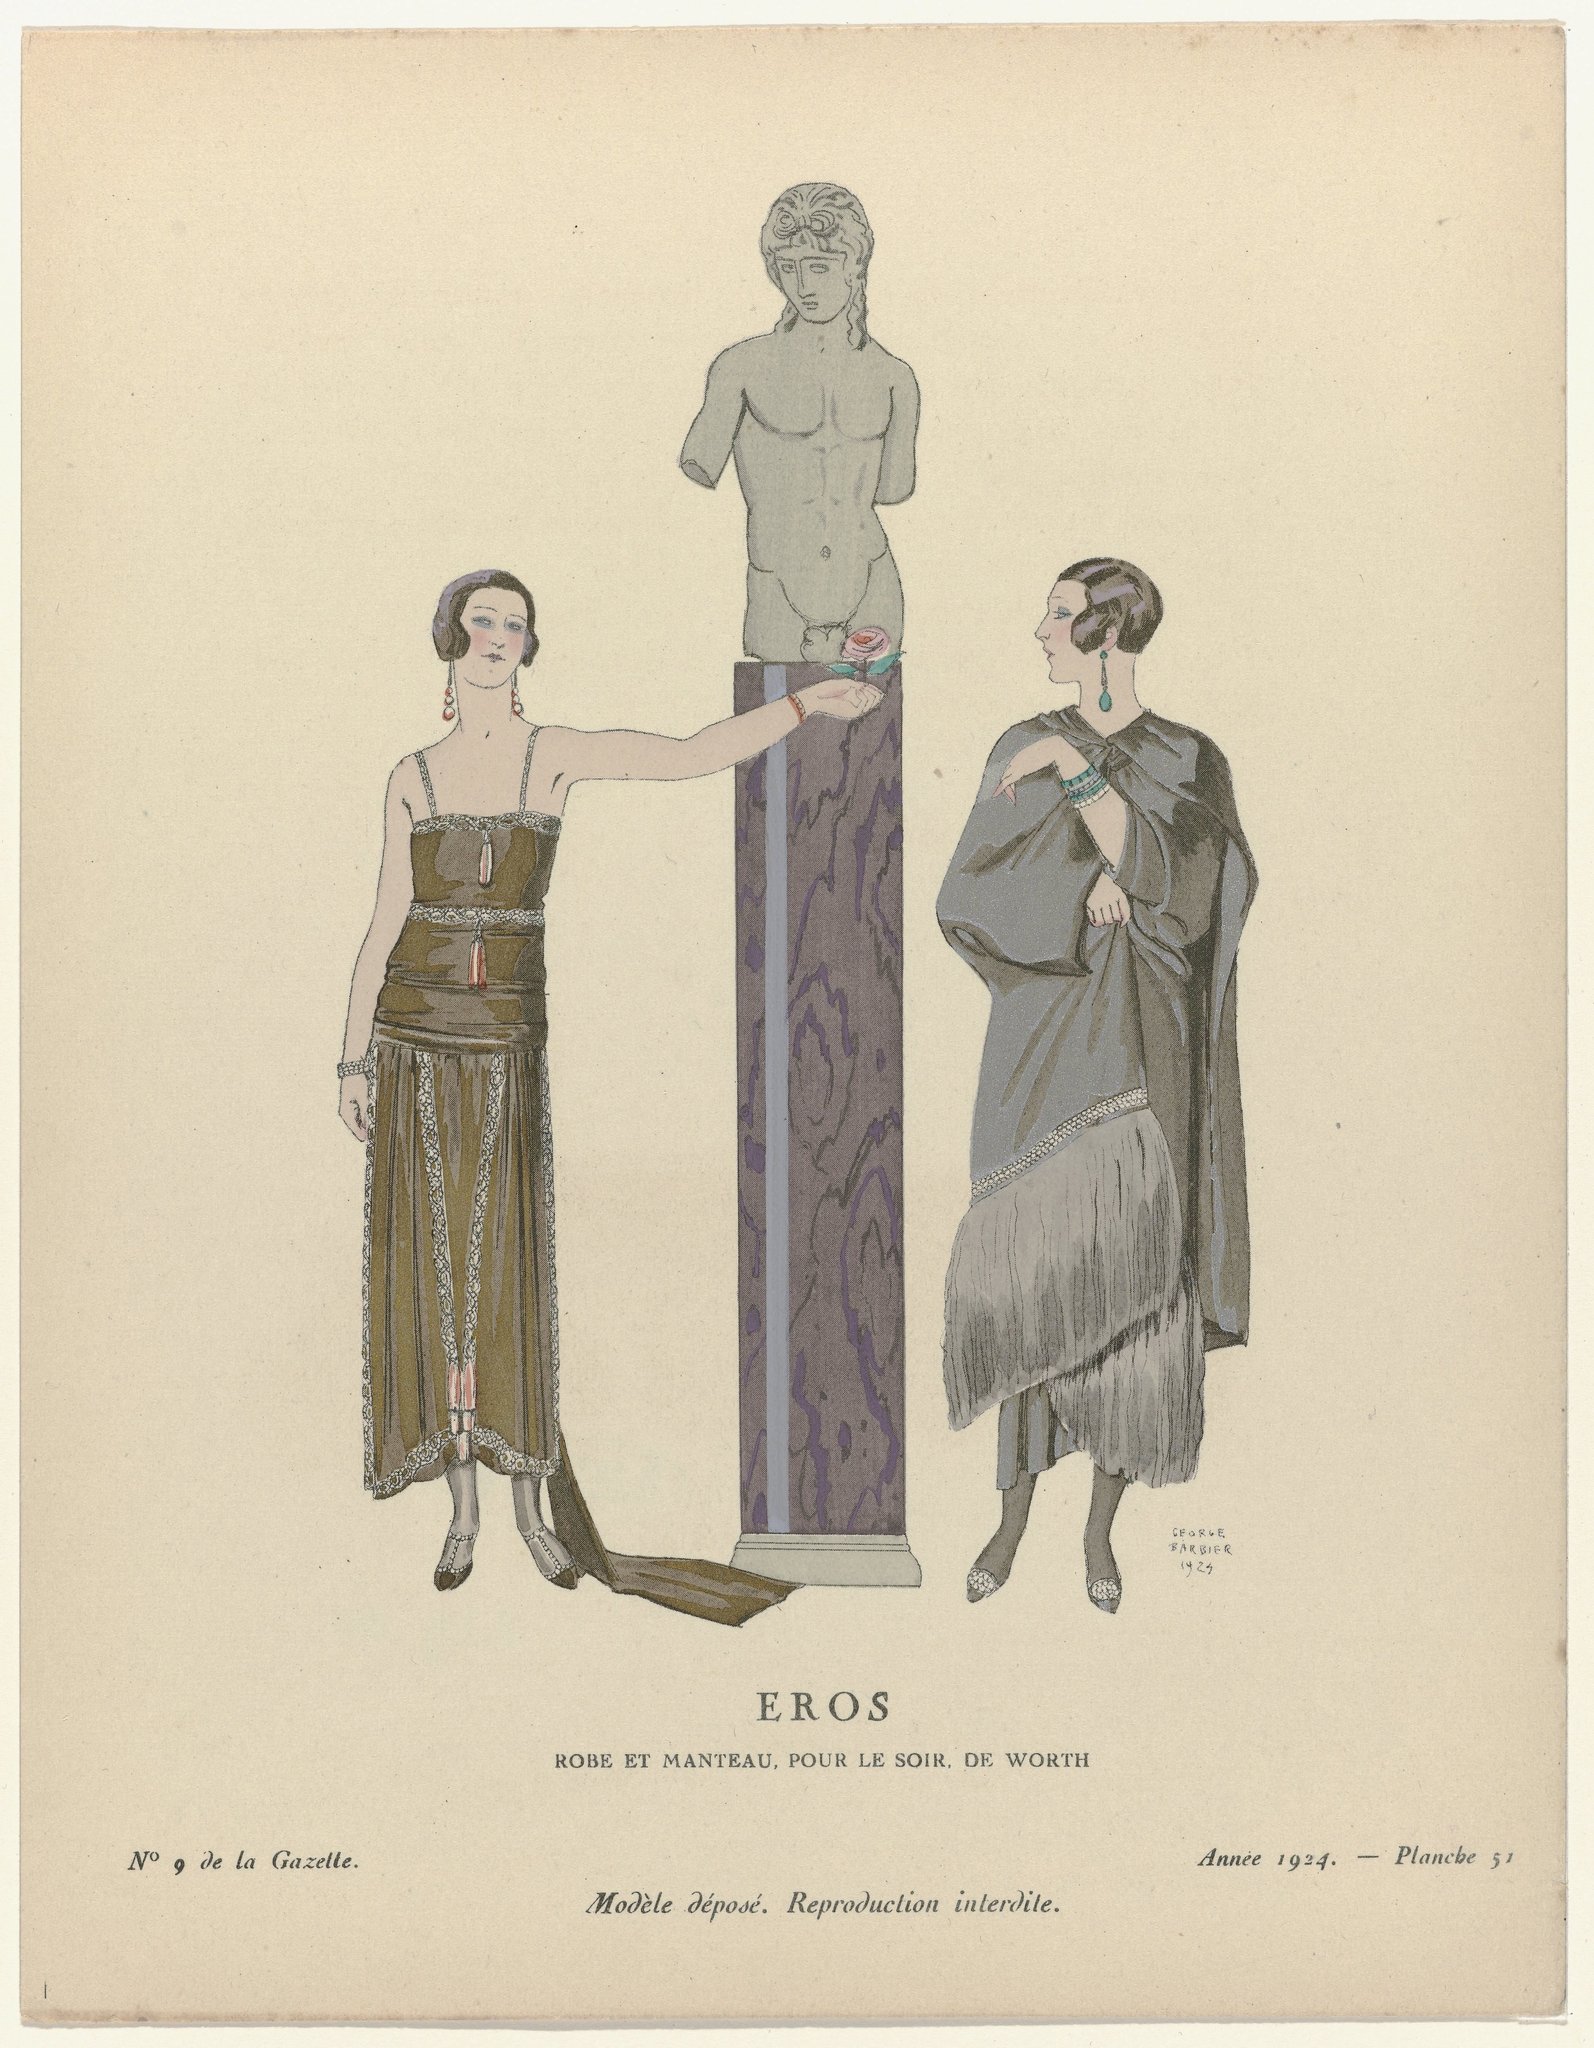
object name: fashion print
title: Gazette du Bon Ton, 1924, No. 9, Pl. 51: Eros. Robe et manteau pour le soir, de Worth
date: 1924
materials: paper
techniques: hand coloring, letterpress printing, photochemical processes, pochoir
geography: paris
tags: dress, gown: evening dress (+ women's clothes), column, pillar ~ architecture, ornamental parts of clothing (+ fur used for clothes), chest, bust (+ male human being (not to be used where -a- is prescribed)), coat (evening coat) (+ women's clothes), fashion plates, (story of) cupid, amor (eros), flowers: rose, bracelet, wristlet (+ women's clothes)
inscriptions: inscription: ‘No 9 de la Gazette / Année 1924. - Planche 51 / Modèle déposé. Reproduction interdite.’, caption: ‘EROS / ROBE ET MANTEAU, POUR LE SOIR, DE WORTH’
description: Twee vrouwen staan bij een zuil waarop een buste van de god Eros. De vrouw links draagt een avondjapon met sleep van Worth; de vrouw rechts een avondmantel afgezet met bont van Worth. Planche 51 uit Gazette du Bon Ton 1924, No. 9.